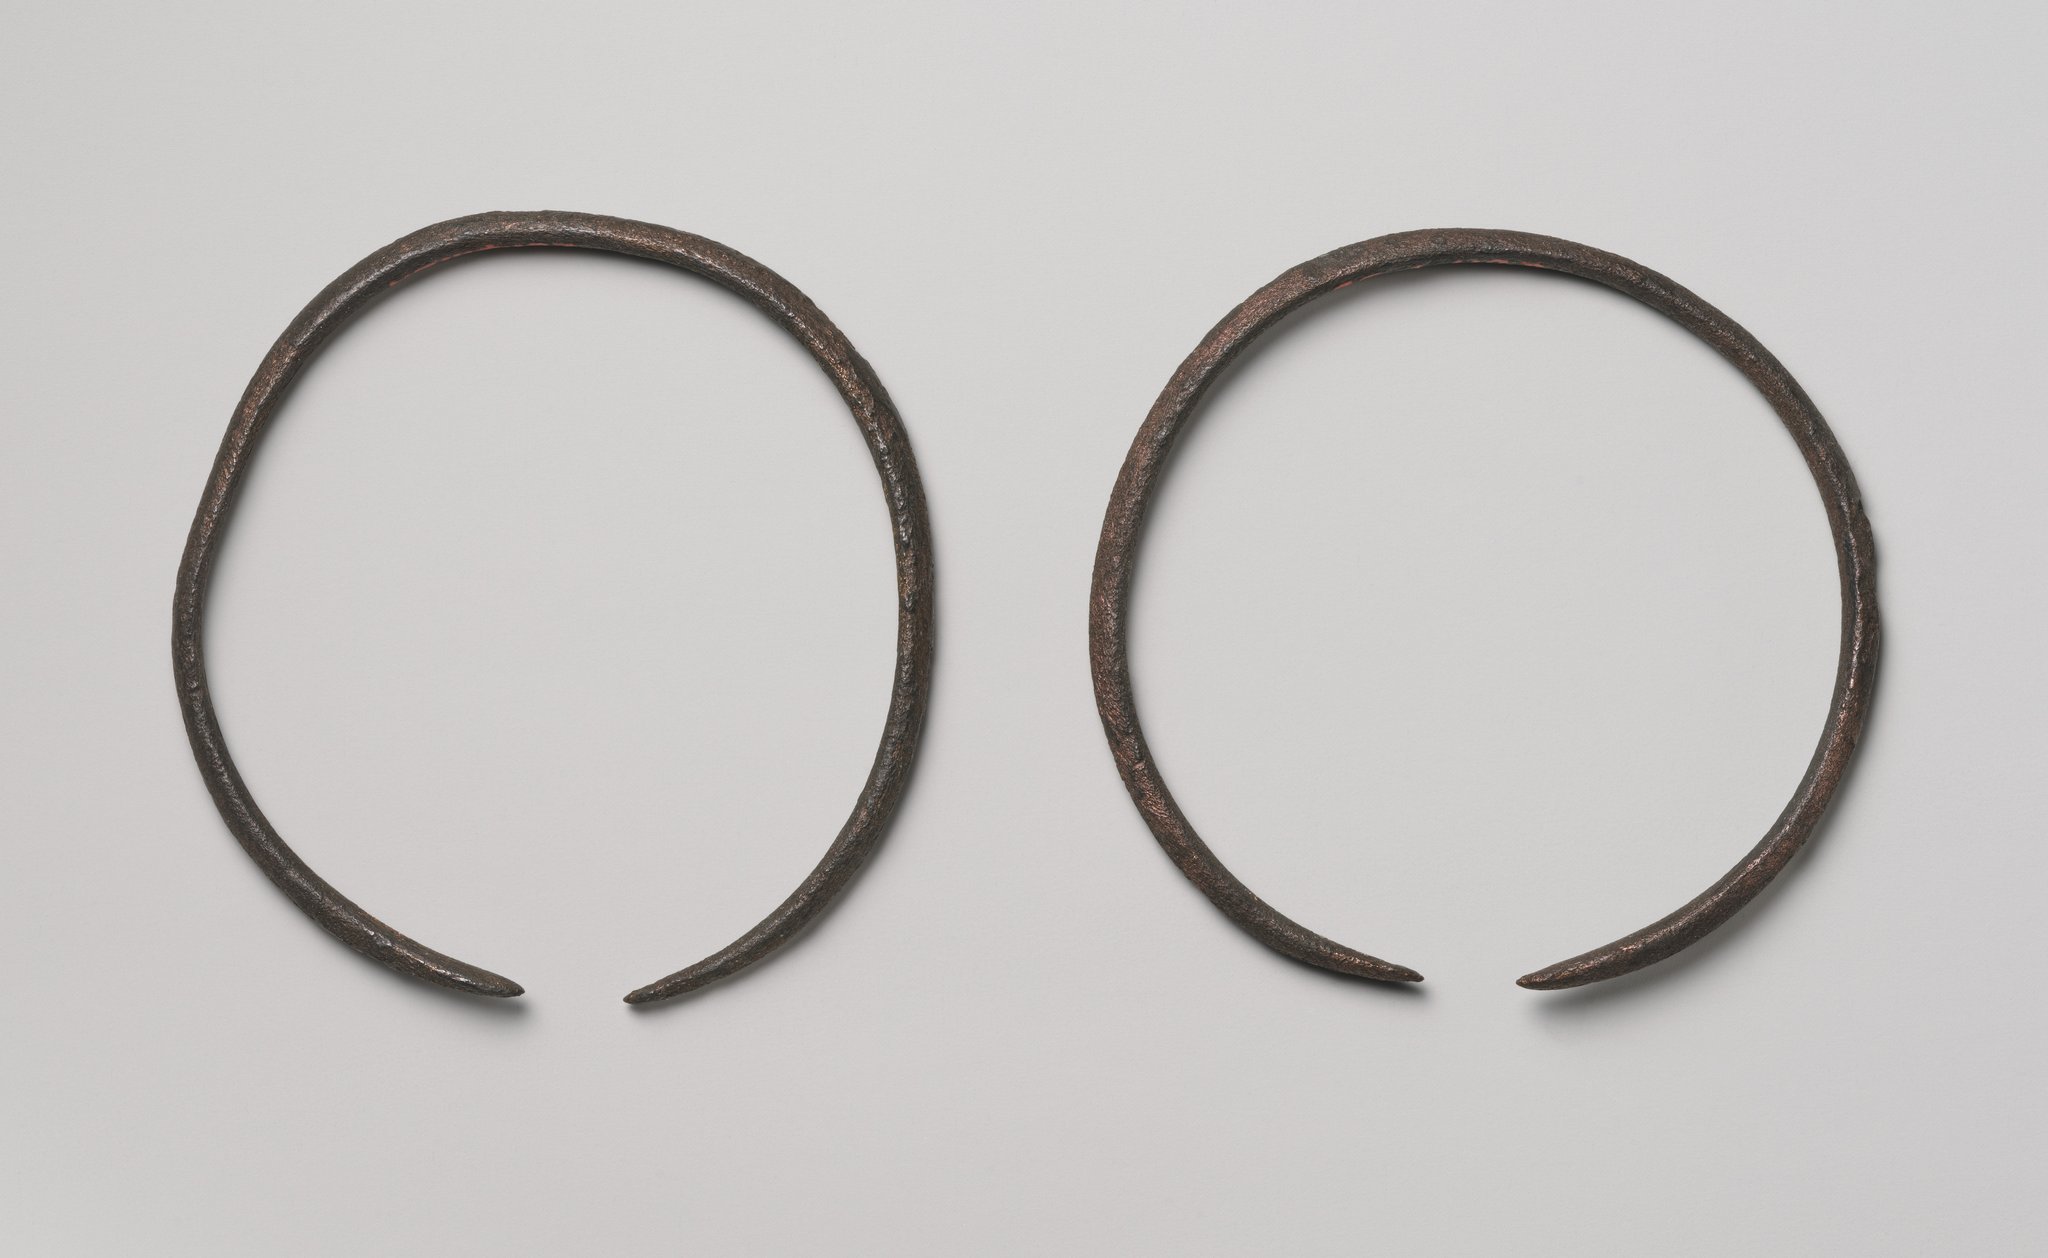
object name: bracelet or anklet, pair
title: A pair of bracelets or anklets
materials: copper alloy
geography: nubia